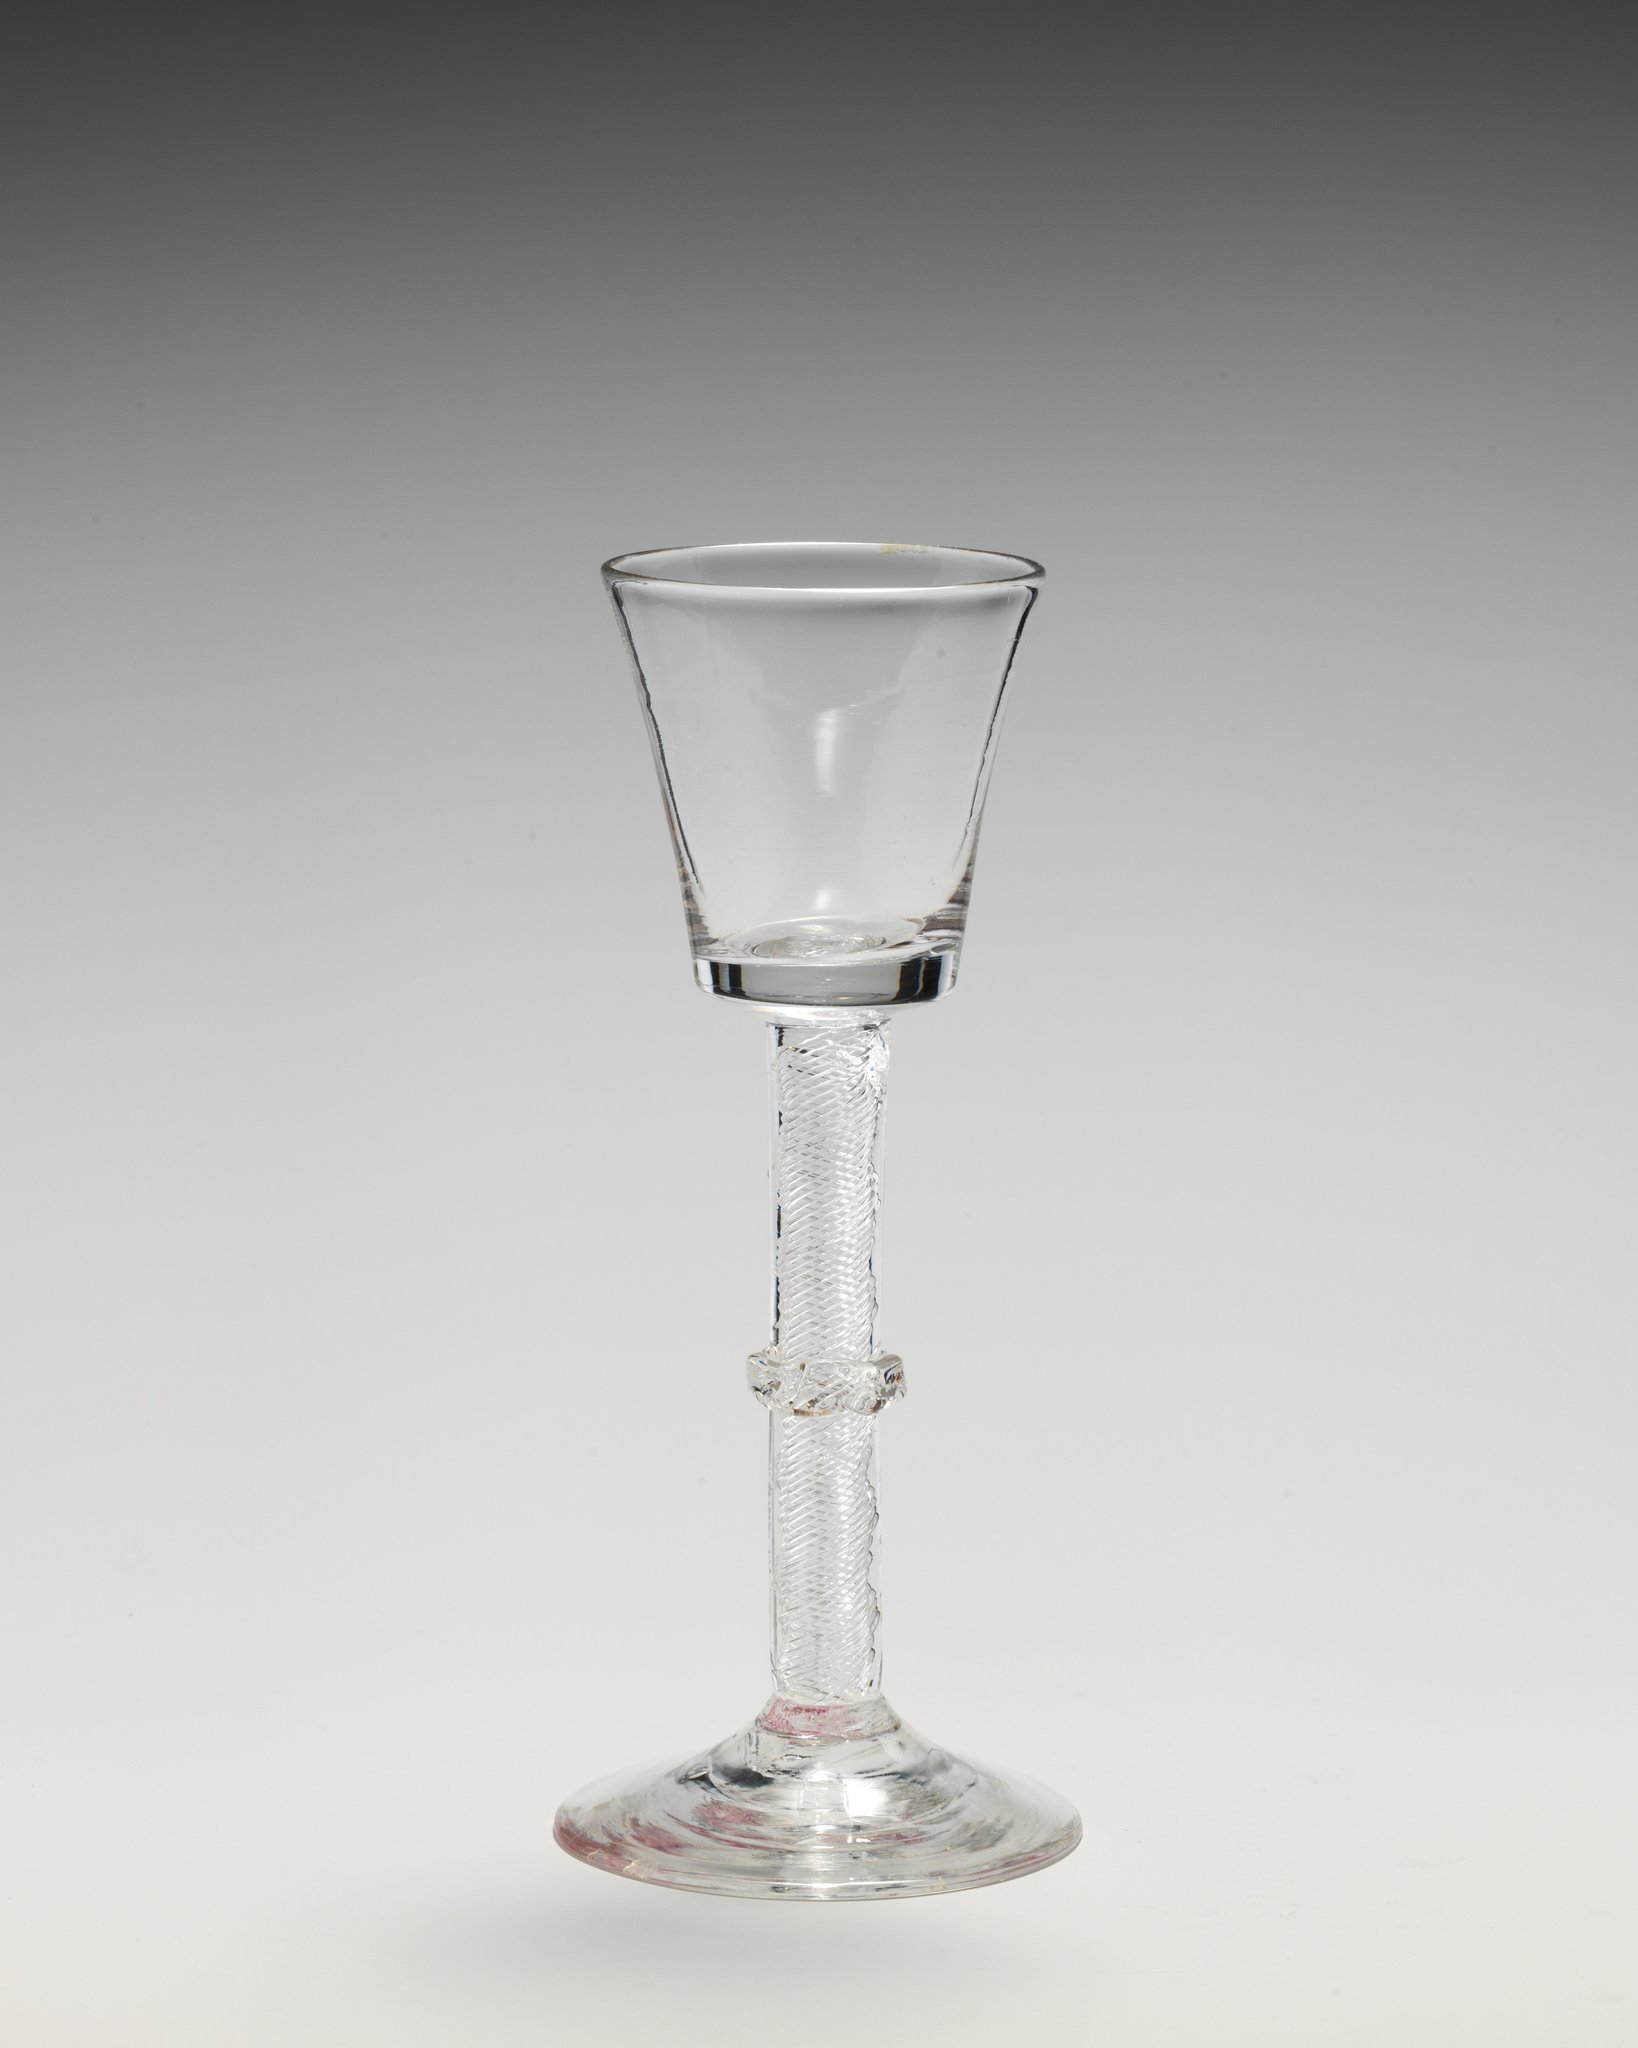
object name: wineglass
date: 1760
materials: glass